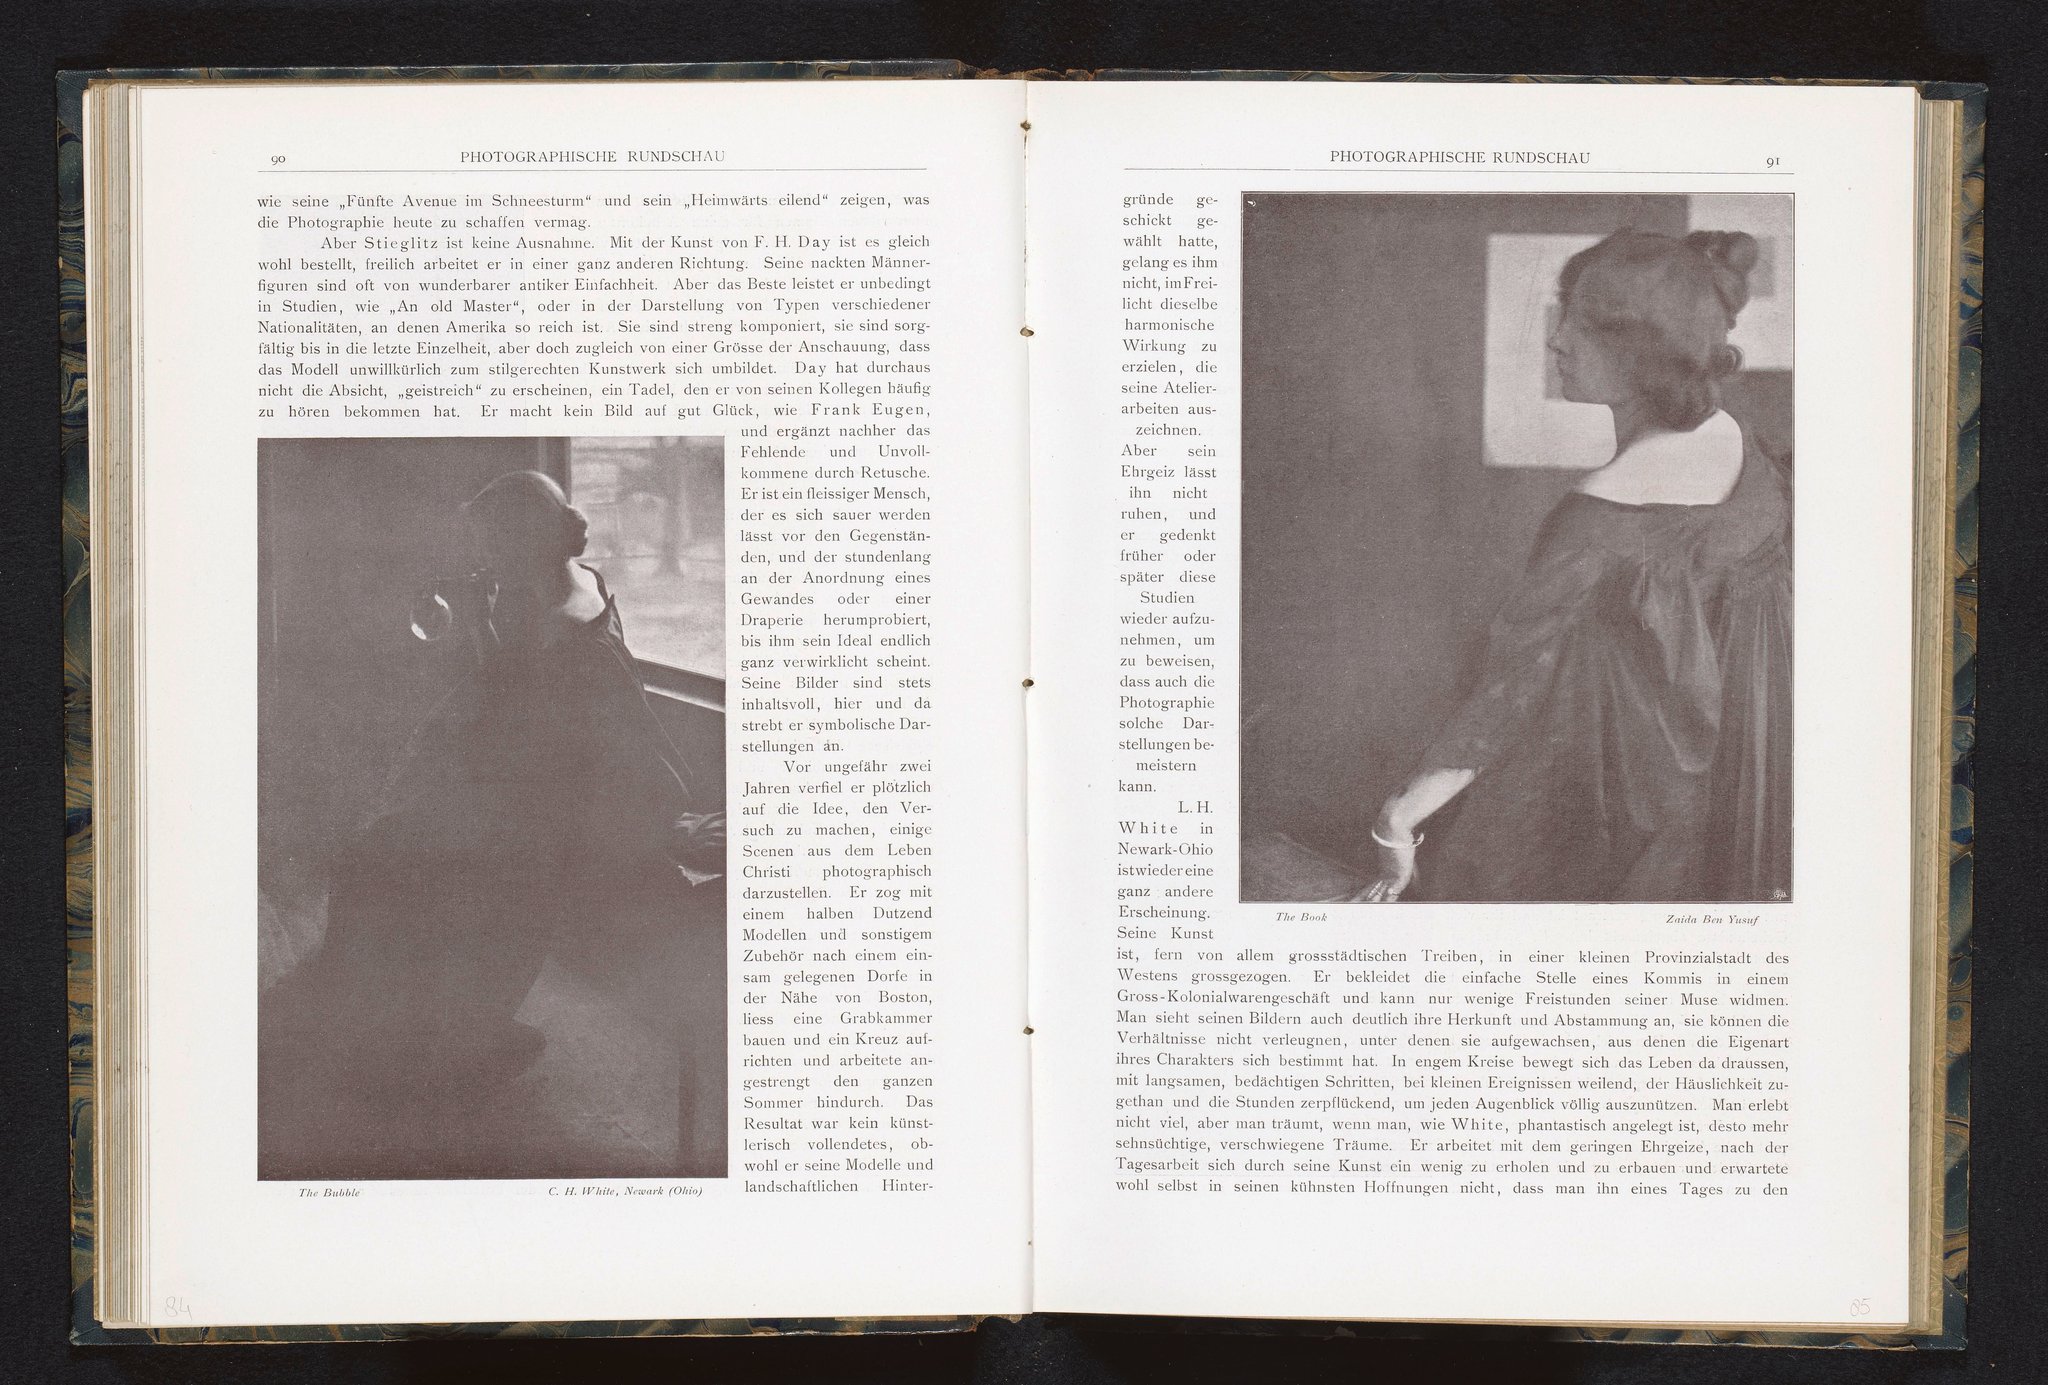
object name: photomechanical print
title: The Book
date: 1895-1900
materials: paper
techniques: autotype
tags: adult woman, anonymous historical person portrayed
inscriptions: monogram: ‘[...]’